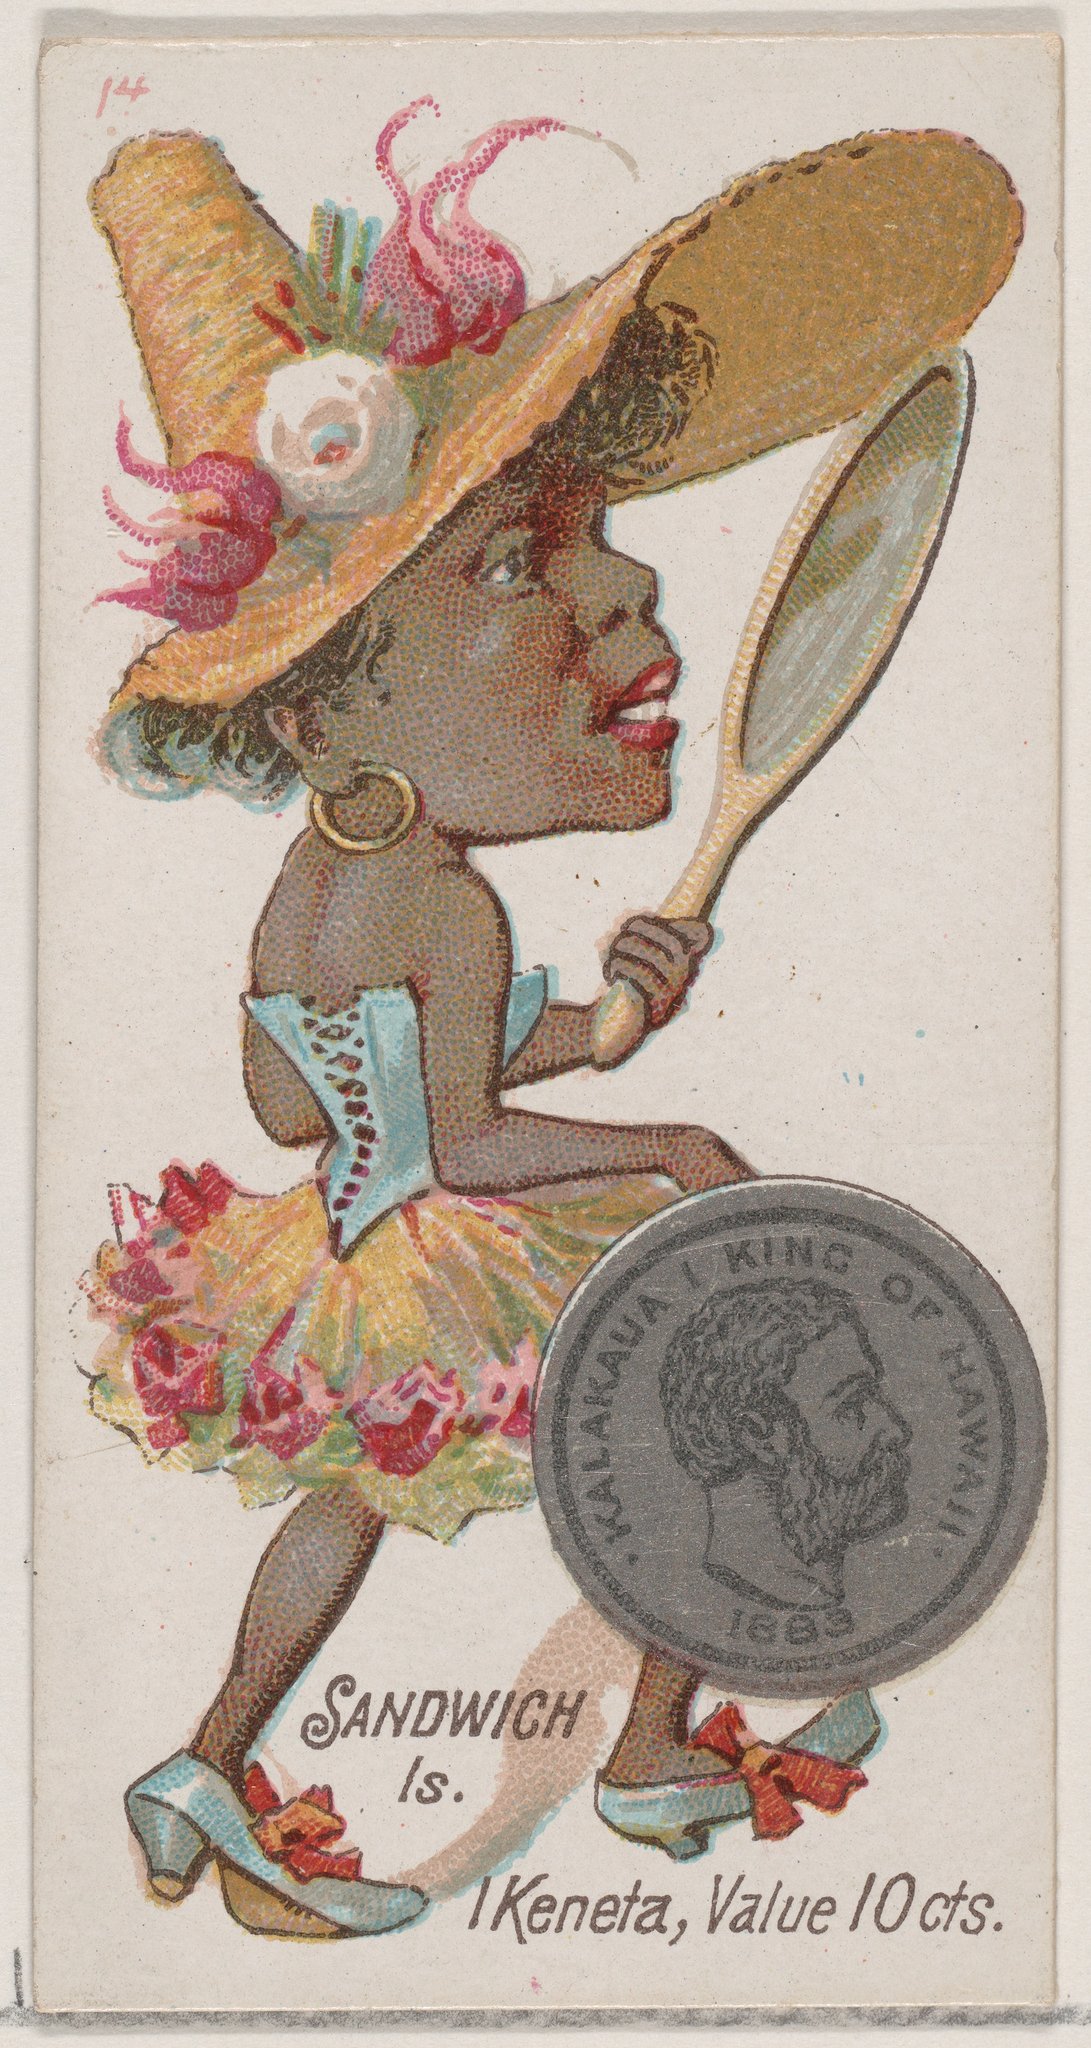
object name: print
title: Caricatured figure from the Sandwich Islands, 1 Keneta, from the series Coins of All Nations (N72, variation 1) for Duke brand cigarettes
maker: w. duke, sons & co.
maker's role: publisher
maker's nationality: american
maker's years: 1870-1920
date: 1889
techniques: color lithograph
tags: women,coins